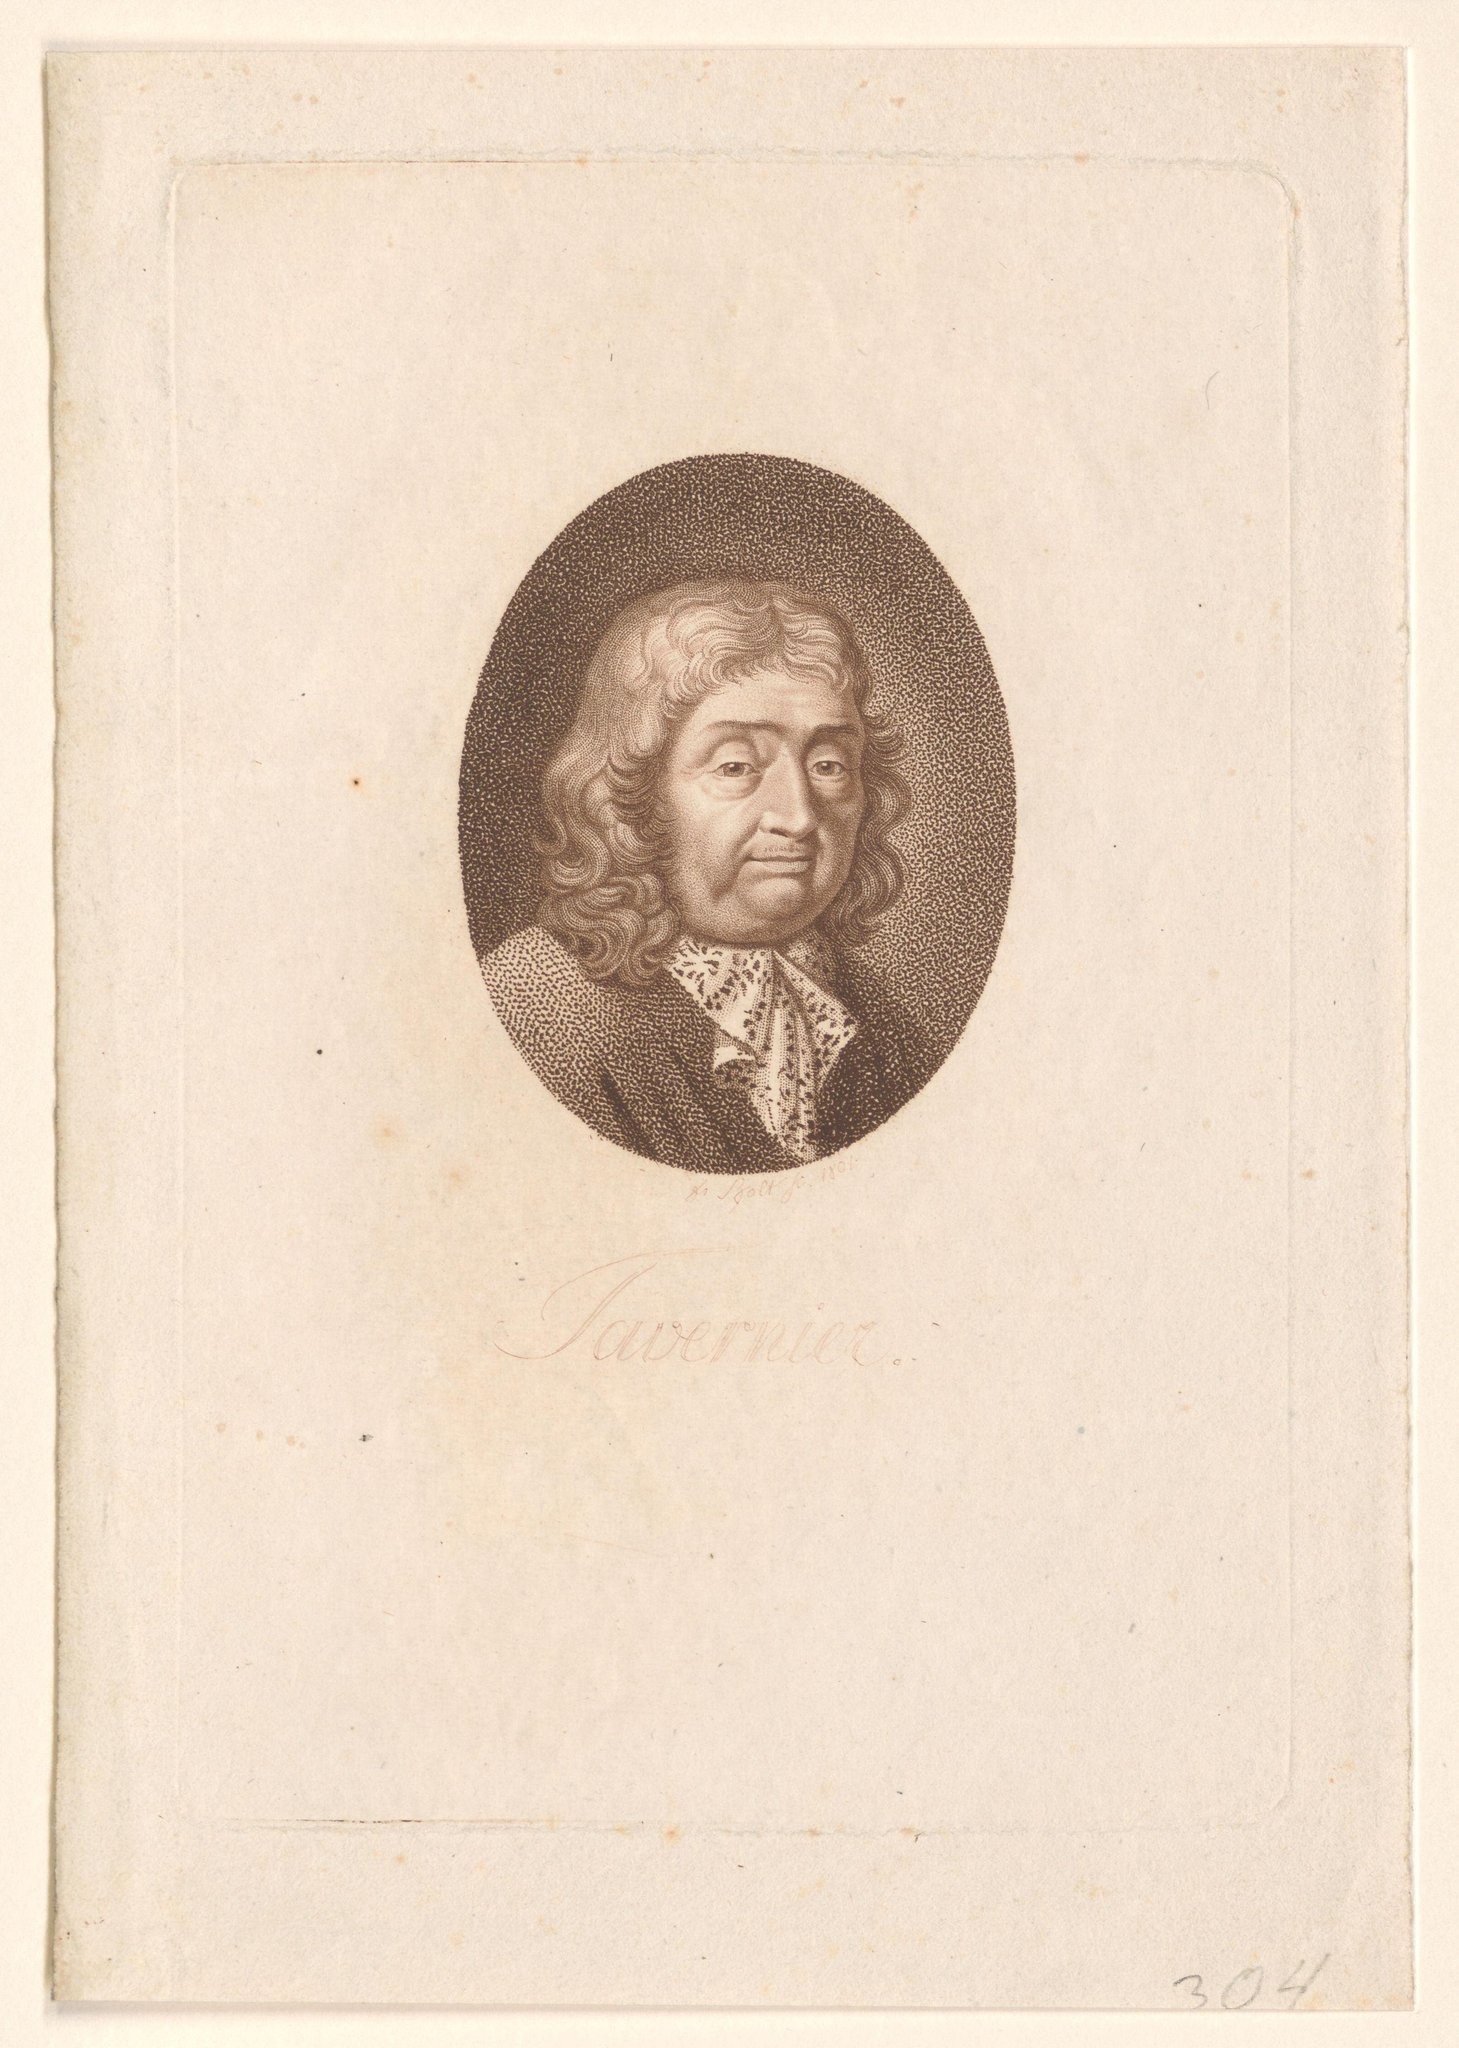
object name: print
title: Portret van Jean-Baptiste Tavernier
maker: johann friedrich bolt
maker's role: print maker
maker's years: 1769-1836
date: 1801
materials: paper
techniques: etching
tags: historical persons, explorer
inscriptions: date